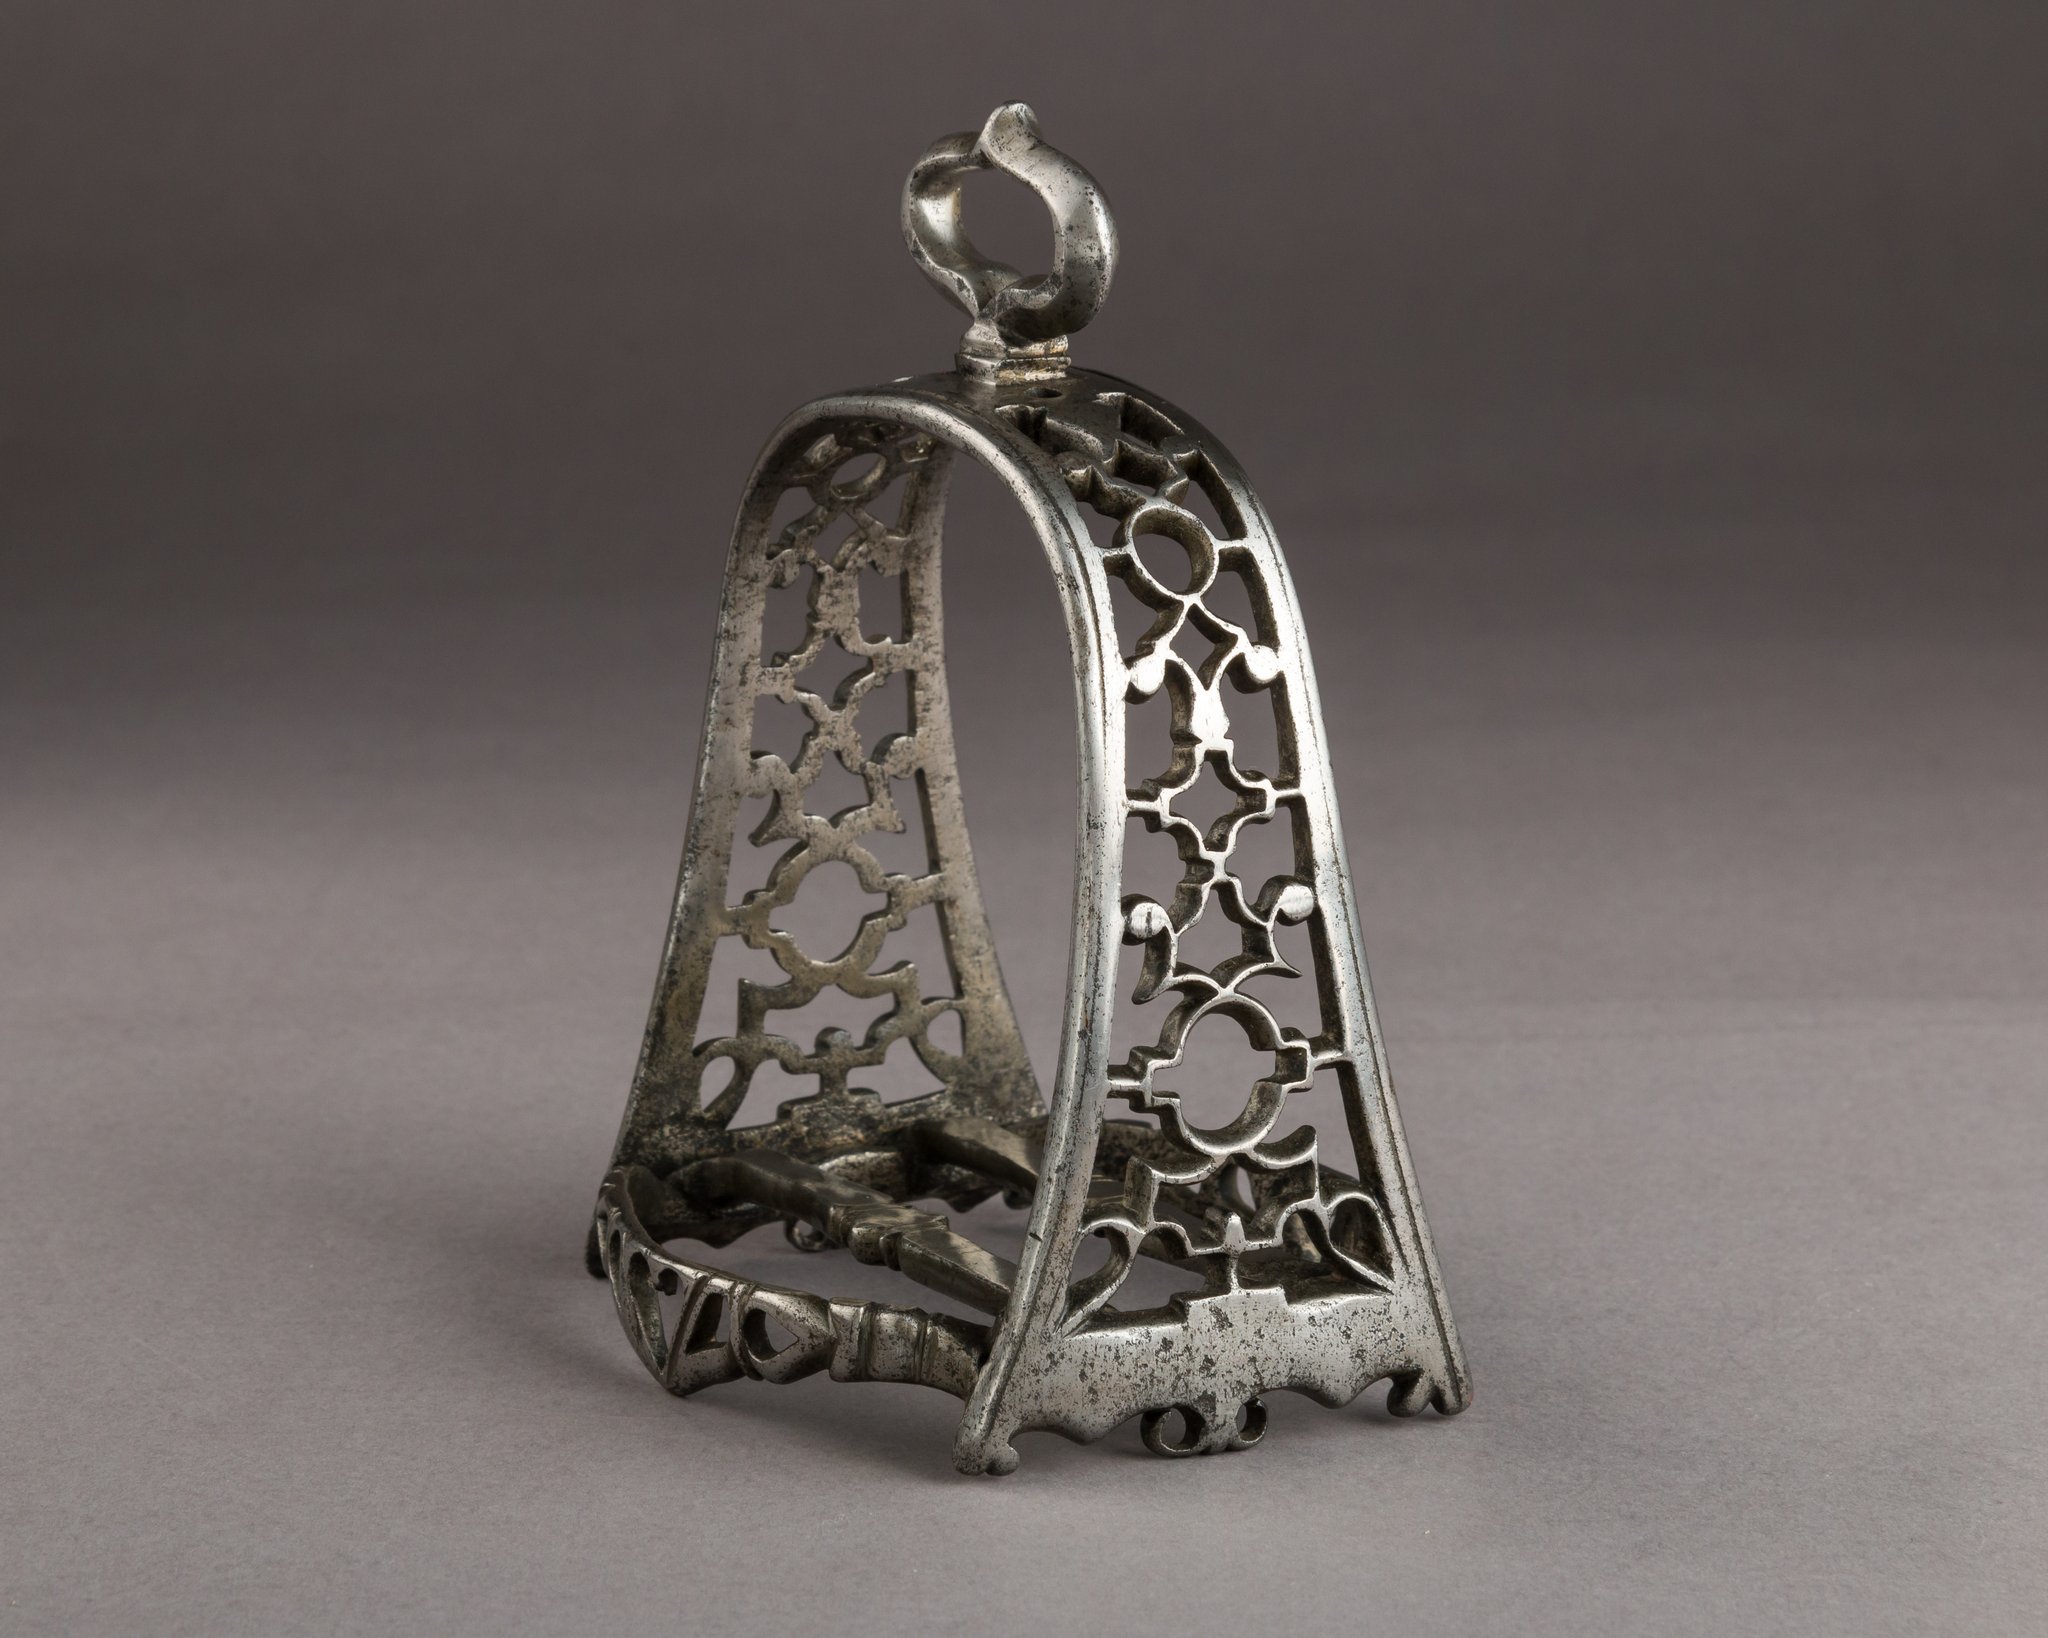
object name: stirrup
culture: italian or spanish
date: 1601-1650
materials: metal alloy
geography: italy